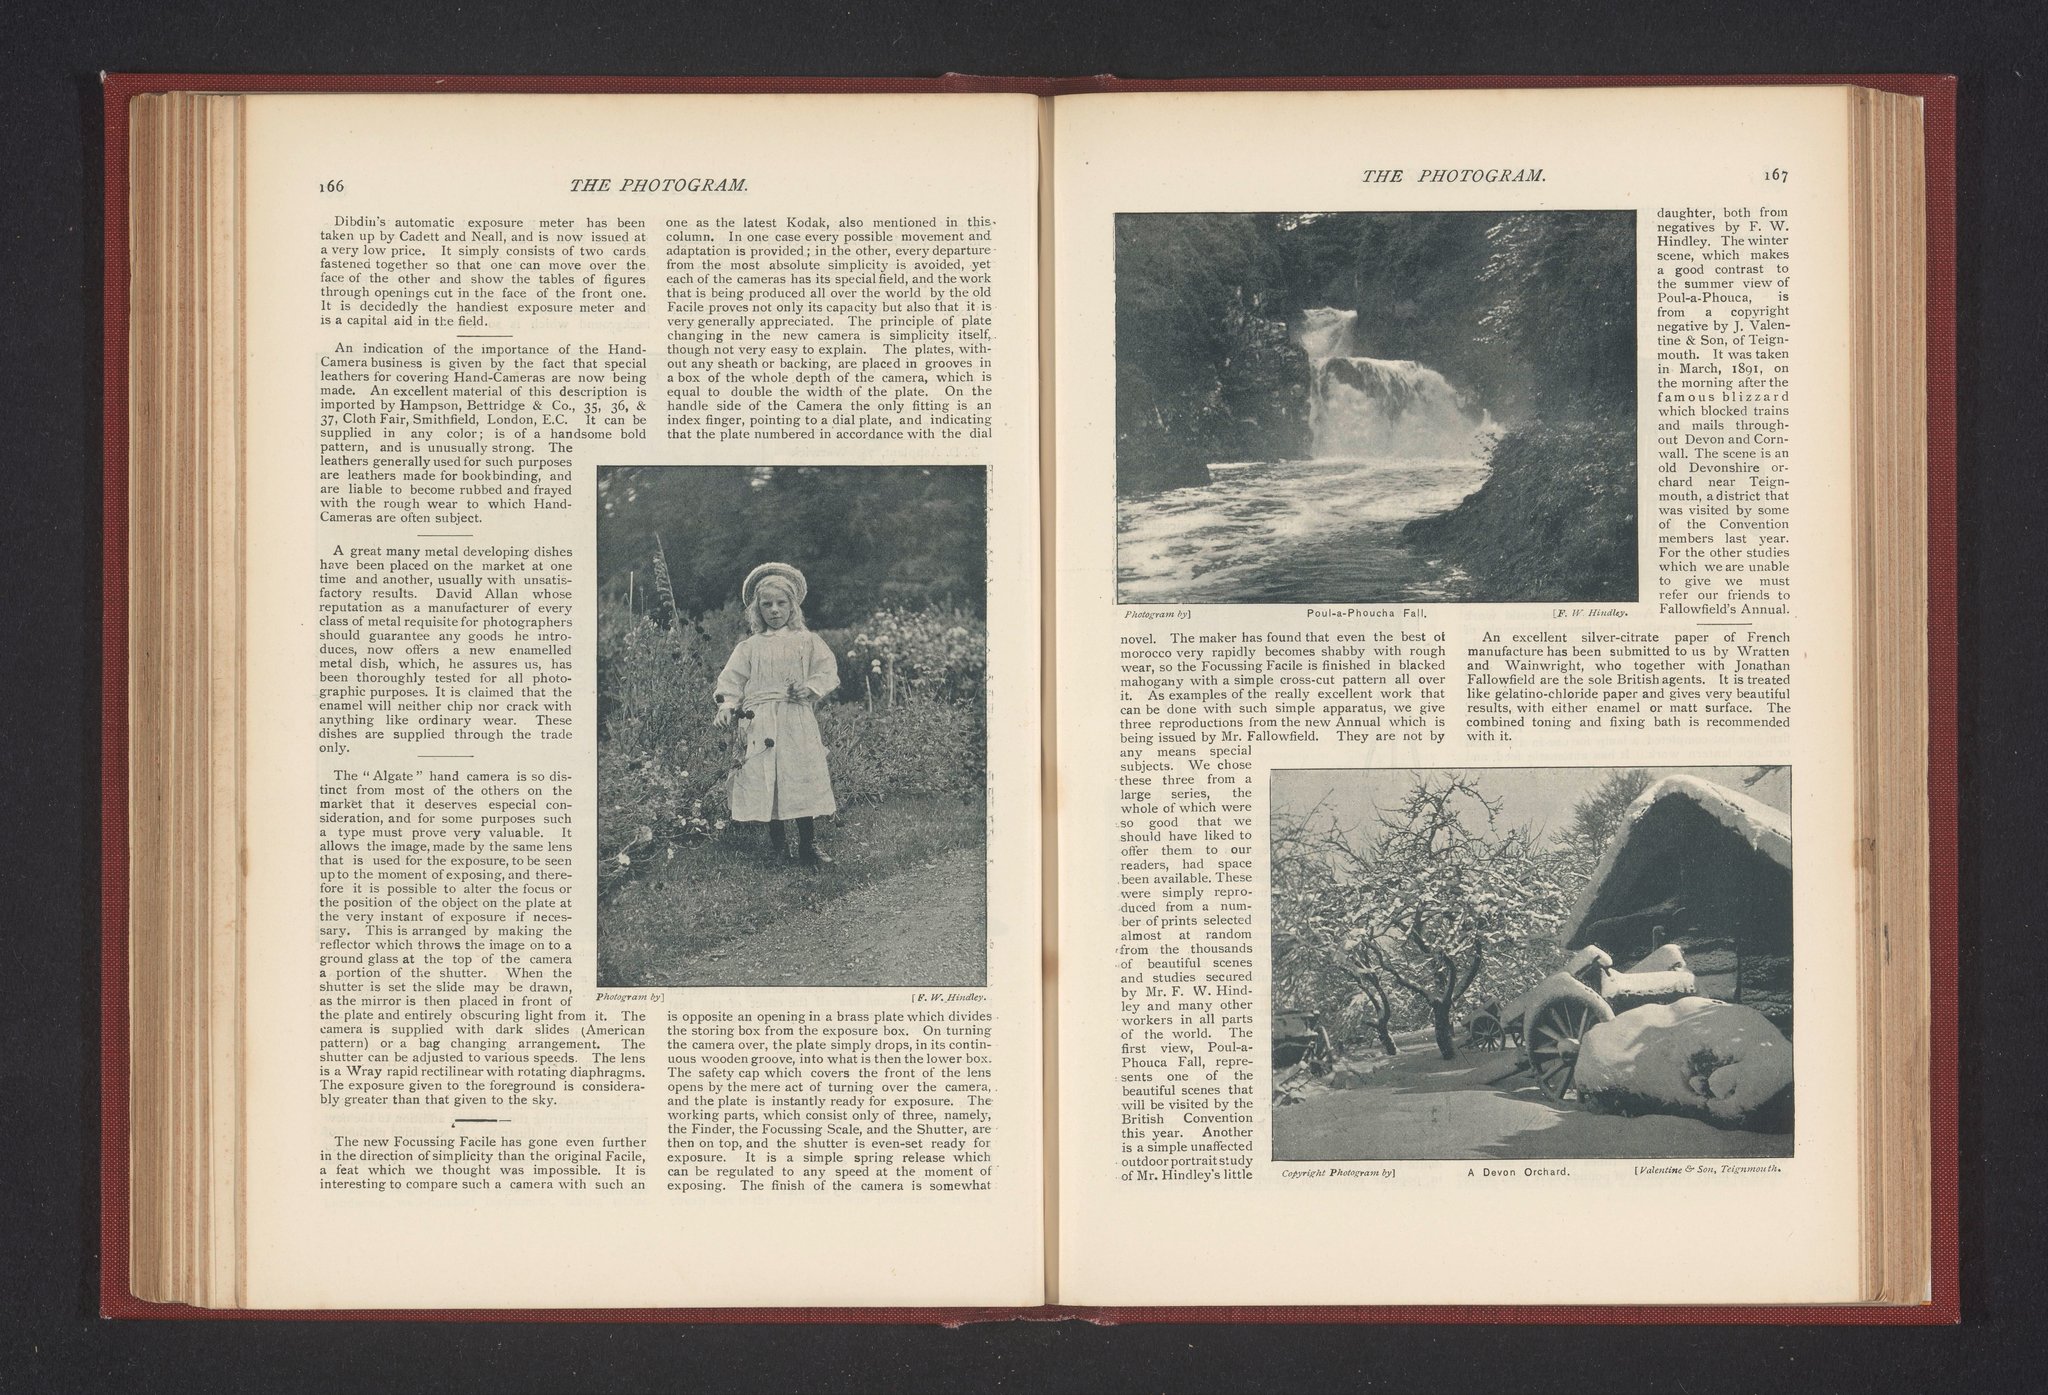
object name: page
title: A Devon orchard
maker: Anonymous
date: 1889-1894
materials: paper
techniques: autotype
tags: snow, orchard